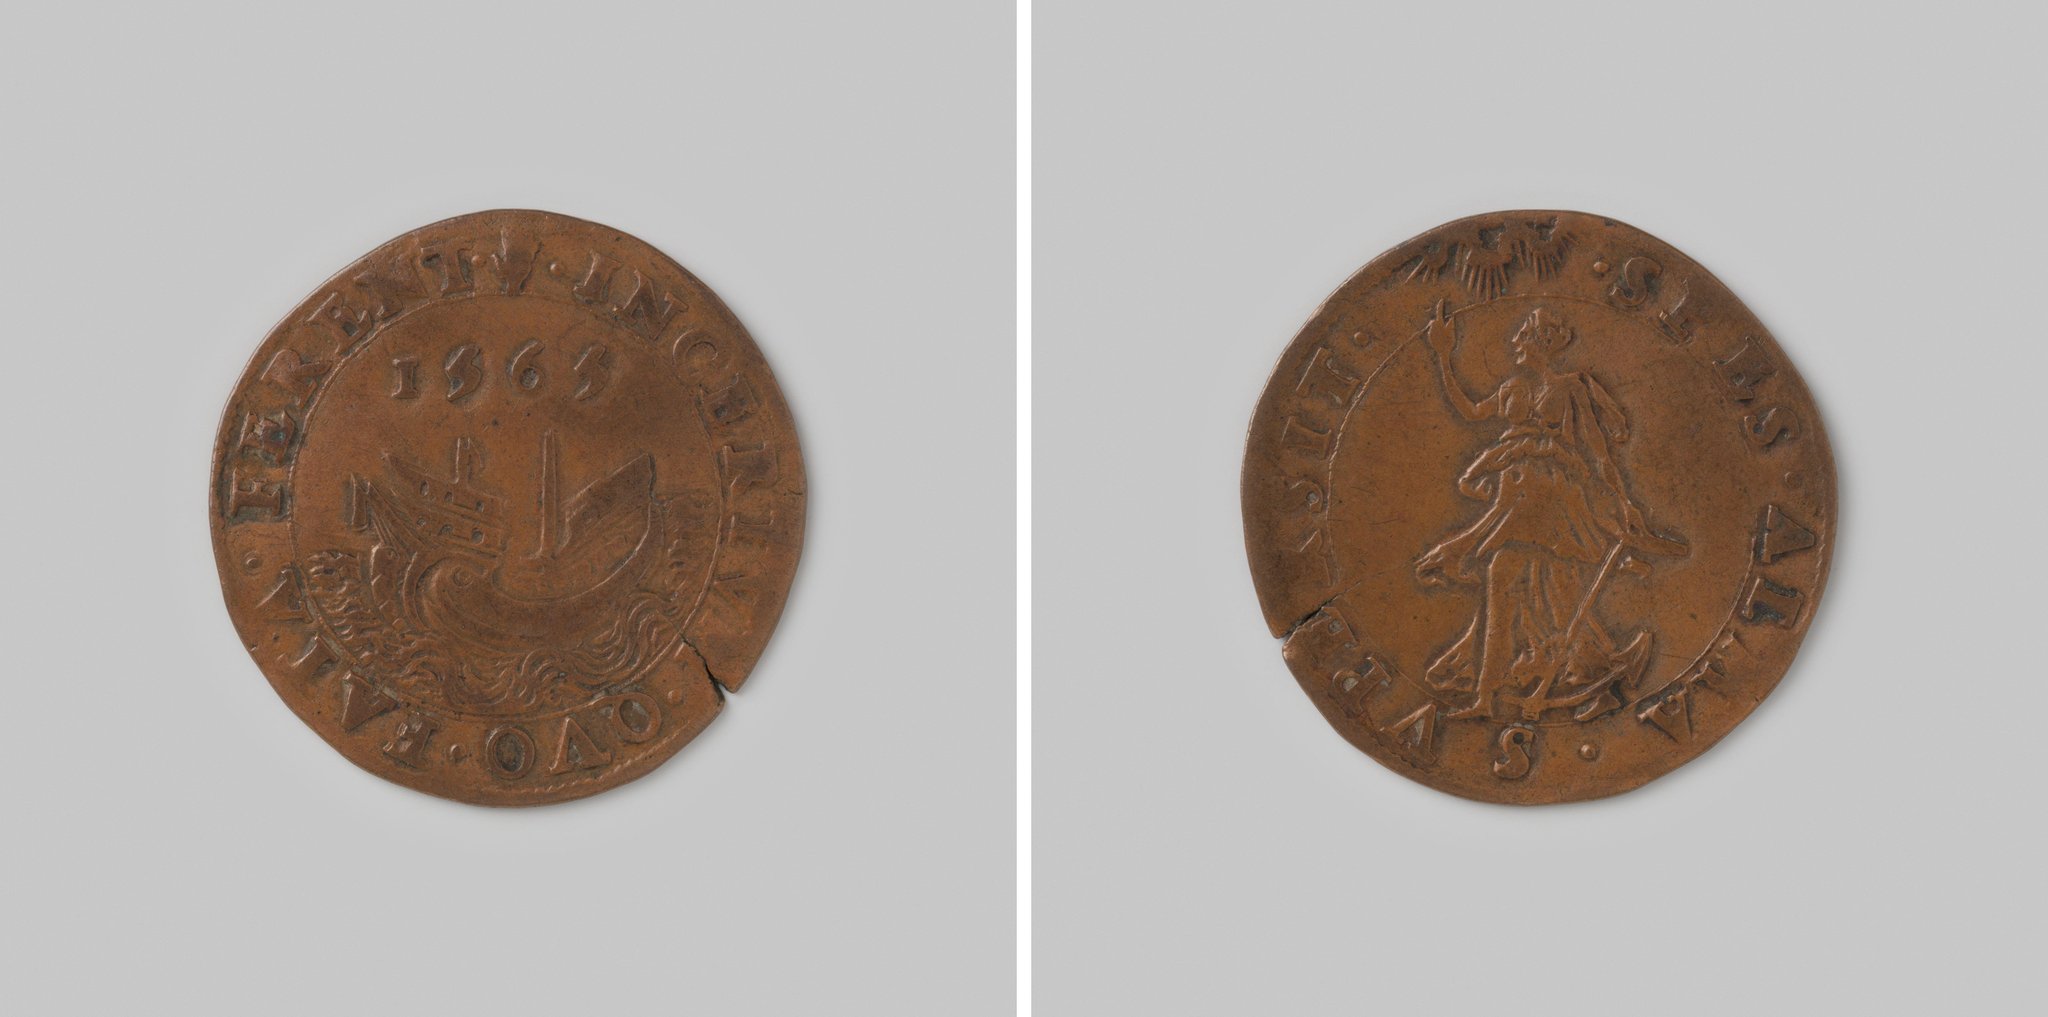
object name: jeton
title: Rekenpenning uit Antwerpen op de moeilijke tijden 1565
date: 1565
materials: copper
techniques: striking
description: Koperen penning, op de voorzijde een schip op woelige zee, met het jaartal in het veld en omschrift, op de keerzijde de Hoop, met anker, wijzend naar de hemel, met omschrift.